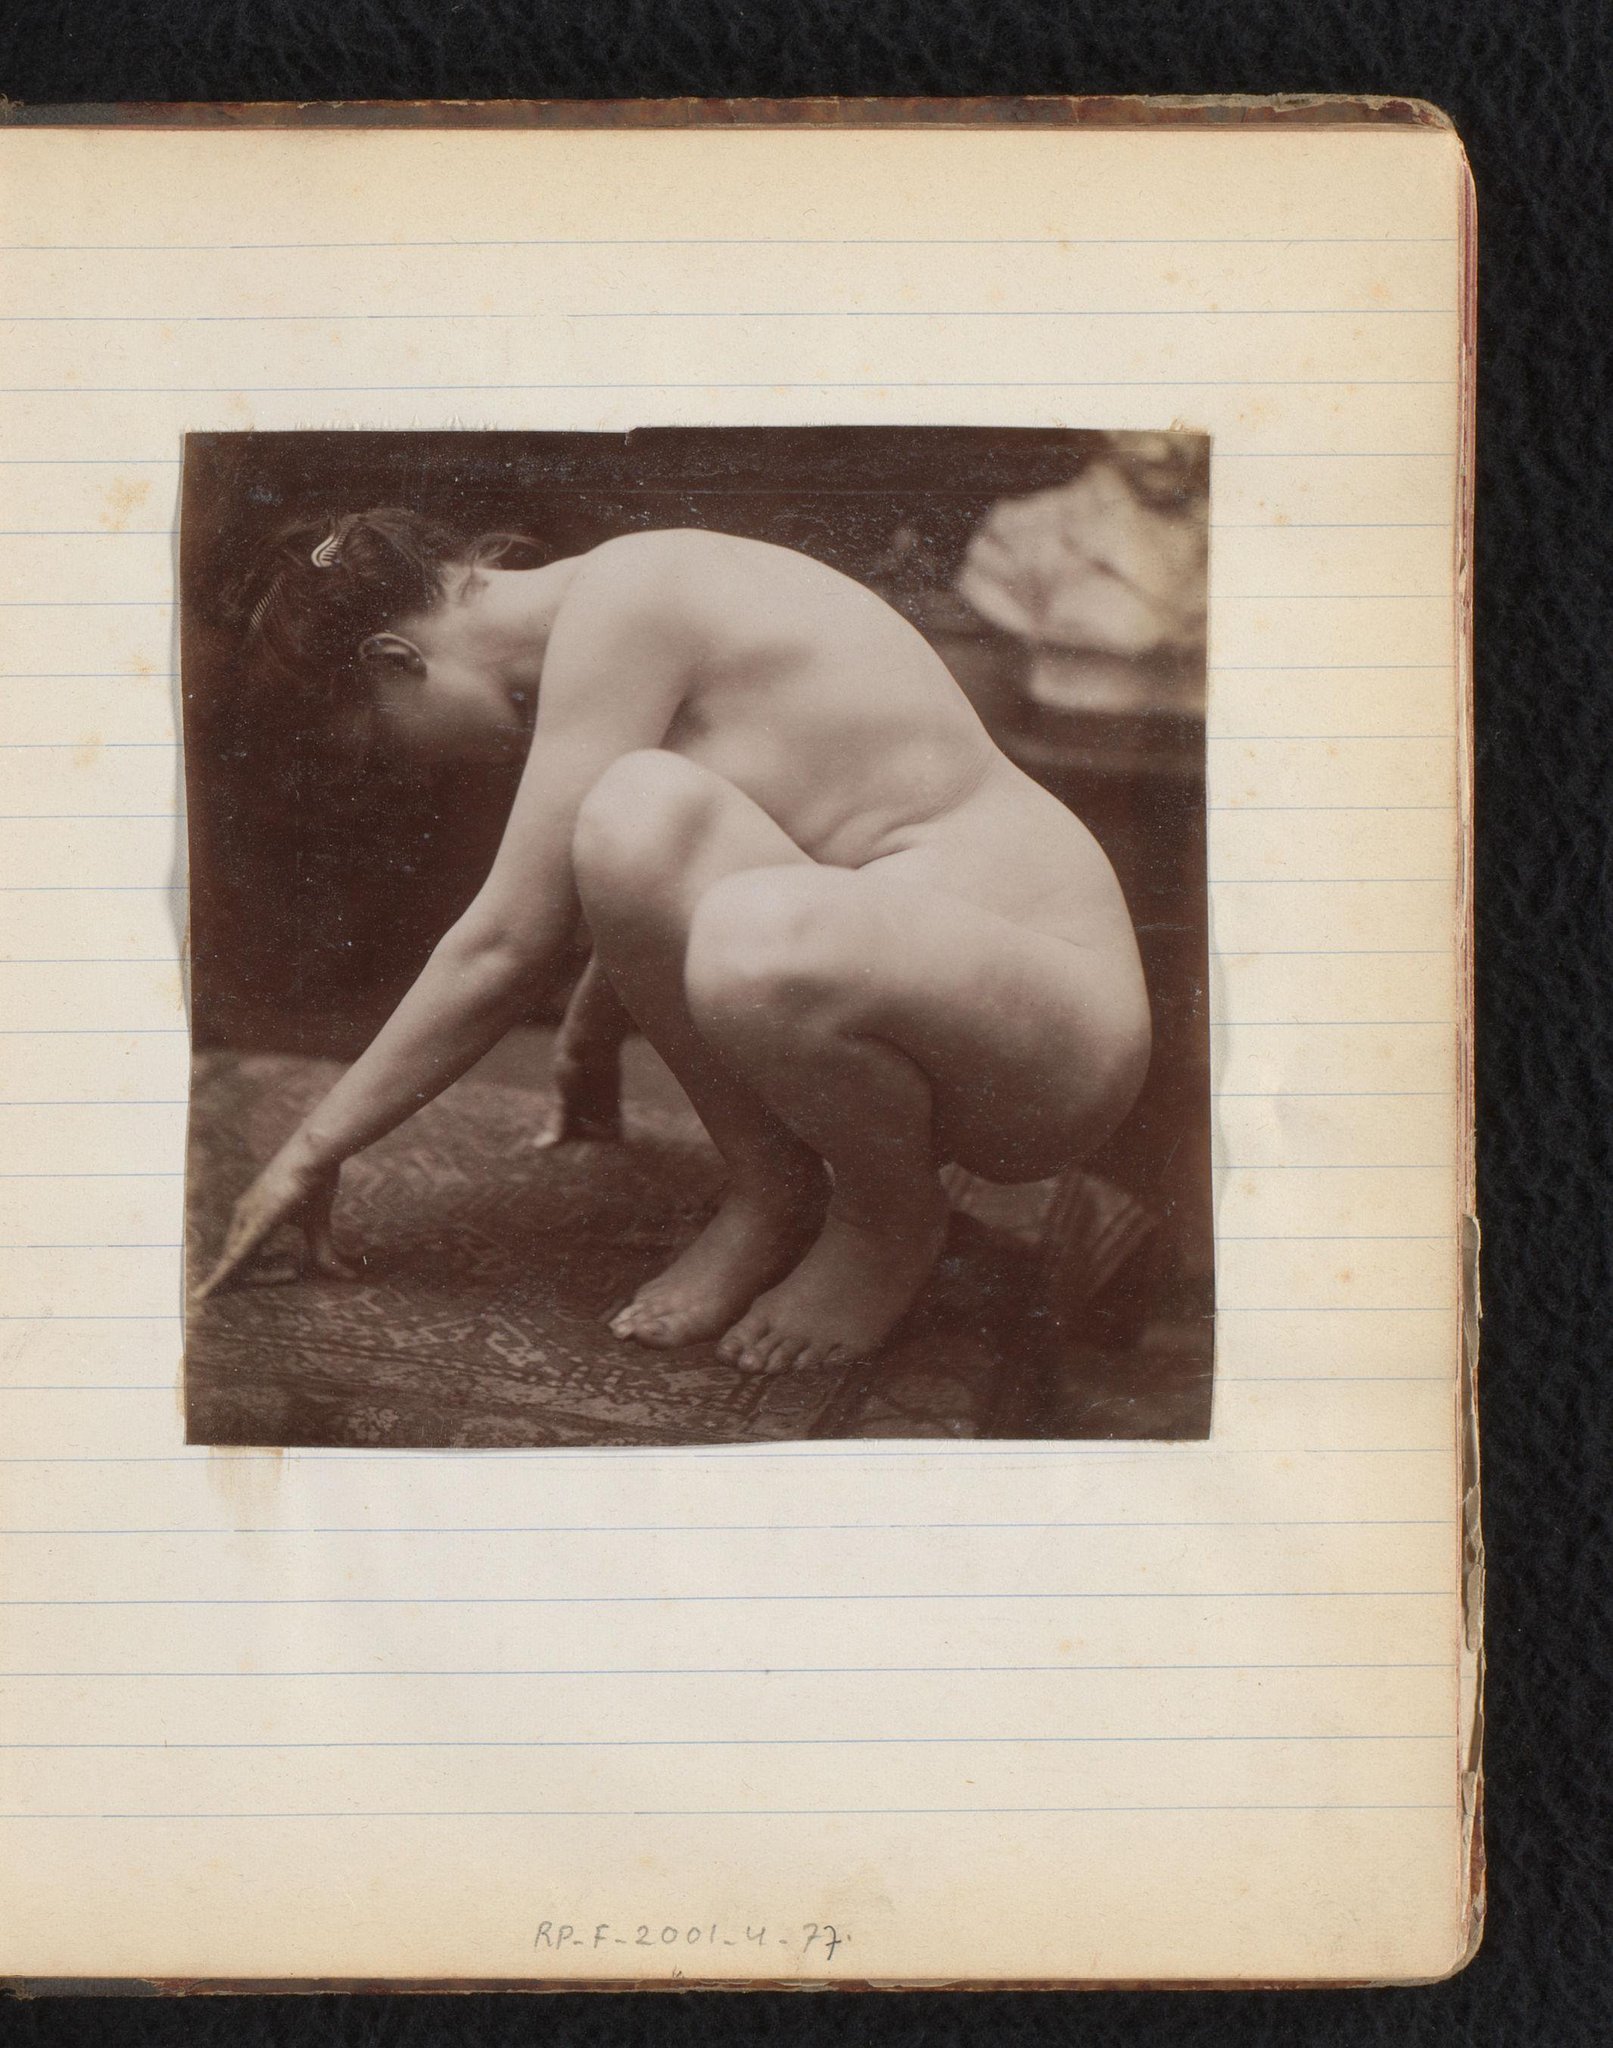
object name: album leaf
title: Studie van een vrouwelijk naaktmodel, van opzij gezien, in het atelier van Jacques de Lalaing, voorstudie voor element voor een fontein in Musee des Beaux arts, Doornik en voor cirkelvormige fontein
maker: jacques lalaing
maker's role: painter, sculptor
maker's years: 1858-1917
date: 1900-1914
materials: photographic support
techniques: albumen print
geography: brussels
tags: adult woman, artist (in general) working from nude model